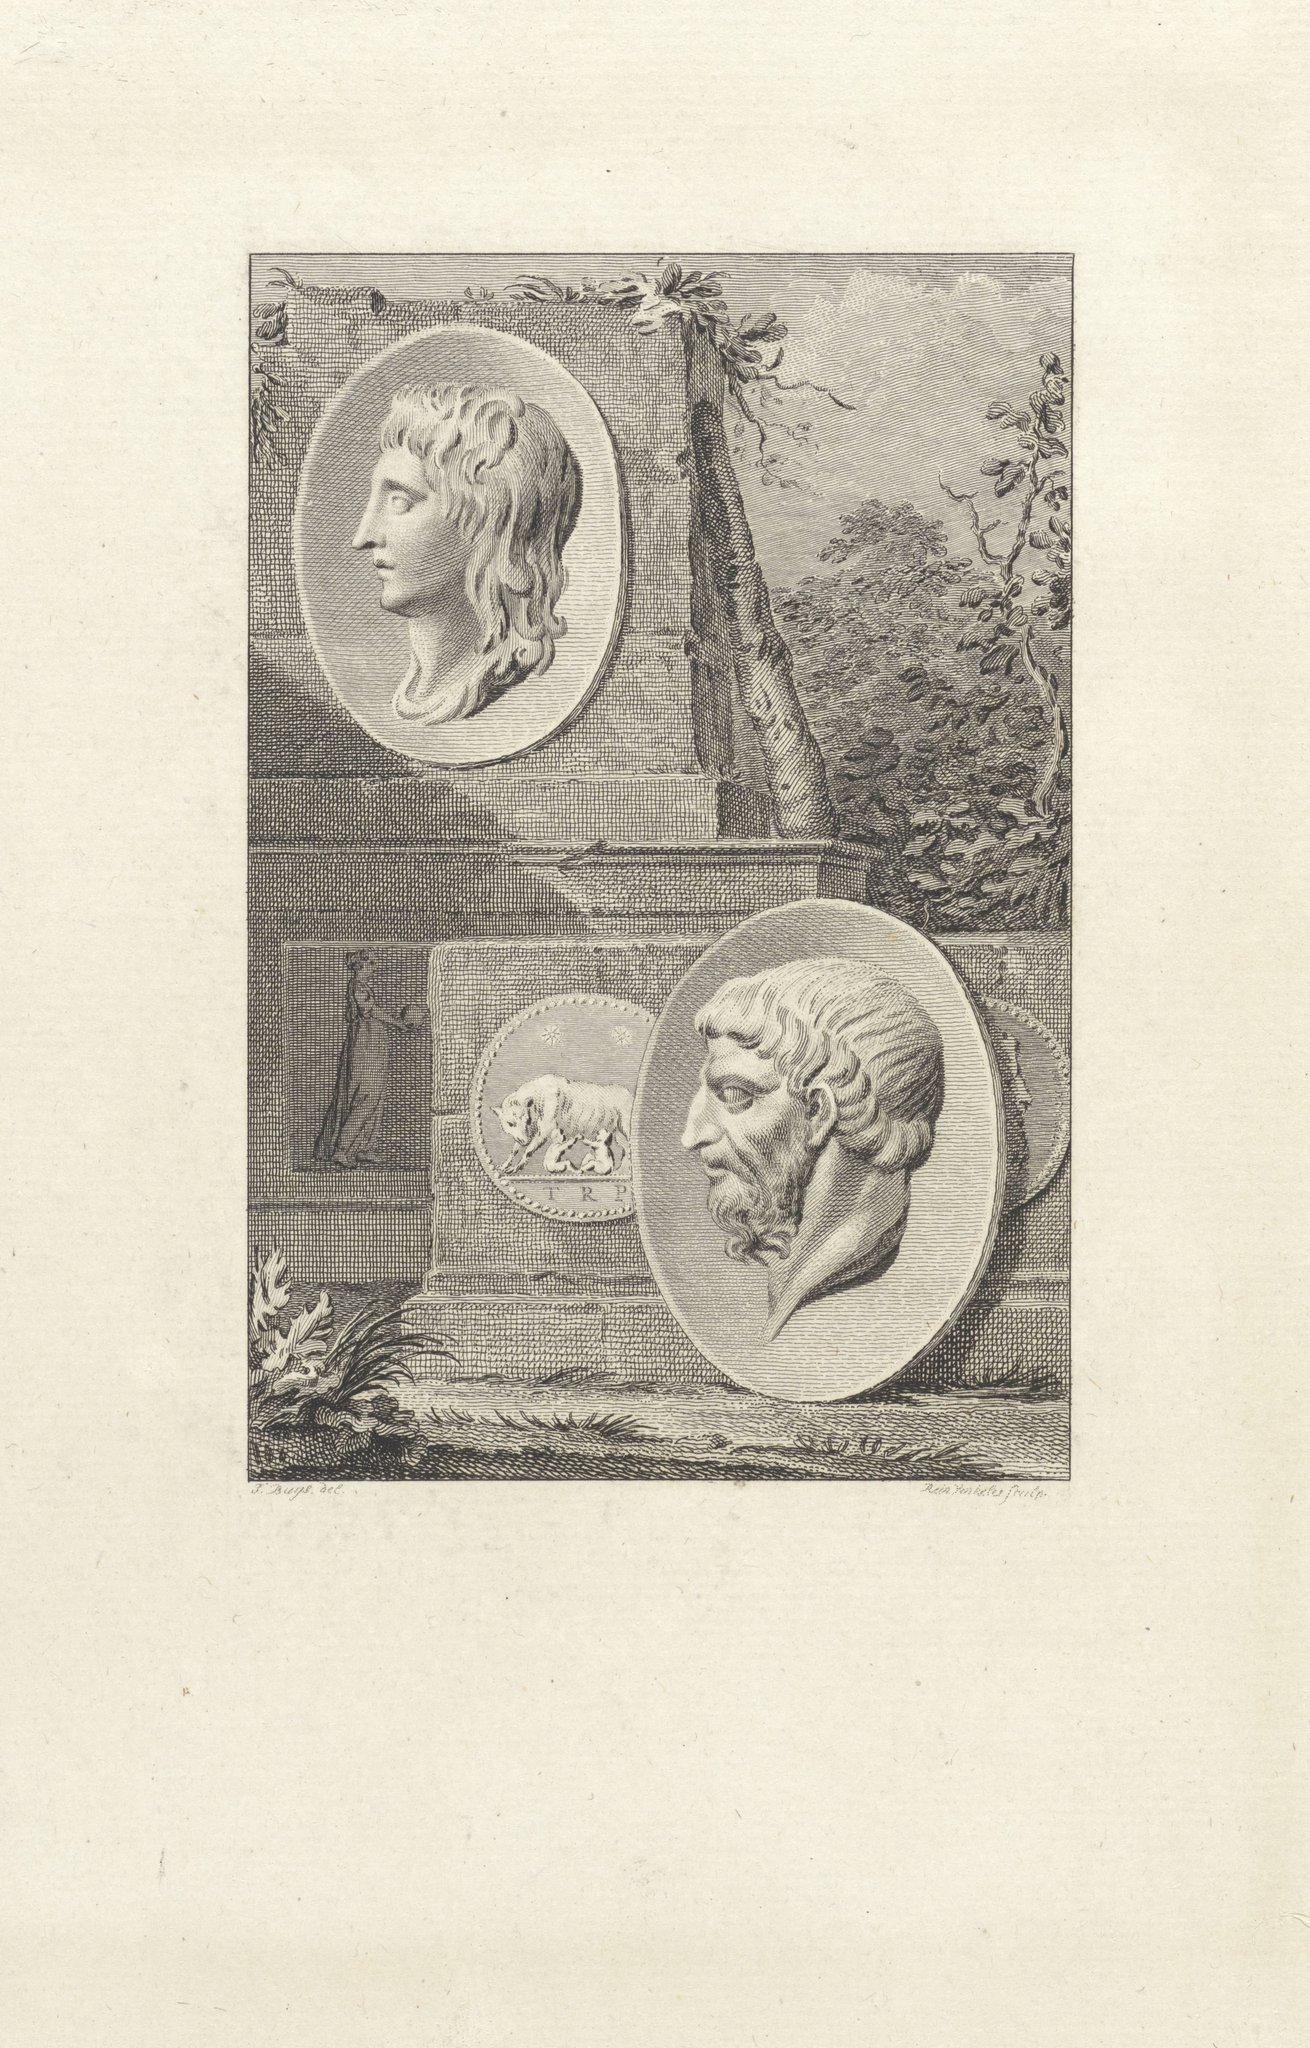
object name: print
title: Medaillons met portretten van Theseus en Romulus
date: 1789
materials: paper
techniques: etching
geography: amsterdam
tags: romulus as king of rome, (story of) theseus, base (~ column, pillar), weapons for striking a blow: club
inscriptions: collector's mark: Lugt 240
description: Medaillons met portretten van de Atheense held Theseus en de Romeinse koning Romulus, tegen stenen sokkels. Naast het portret van Theseus zijn knuppel en bij het portret van Romulus een ander medaillon met de wolvin die Romulus en Remus zoogt.